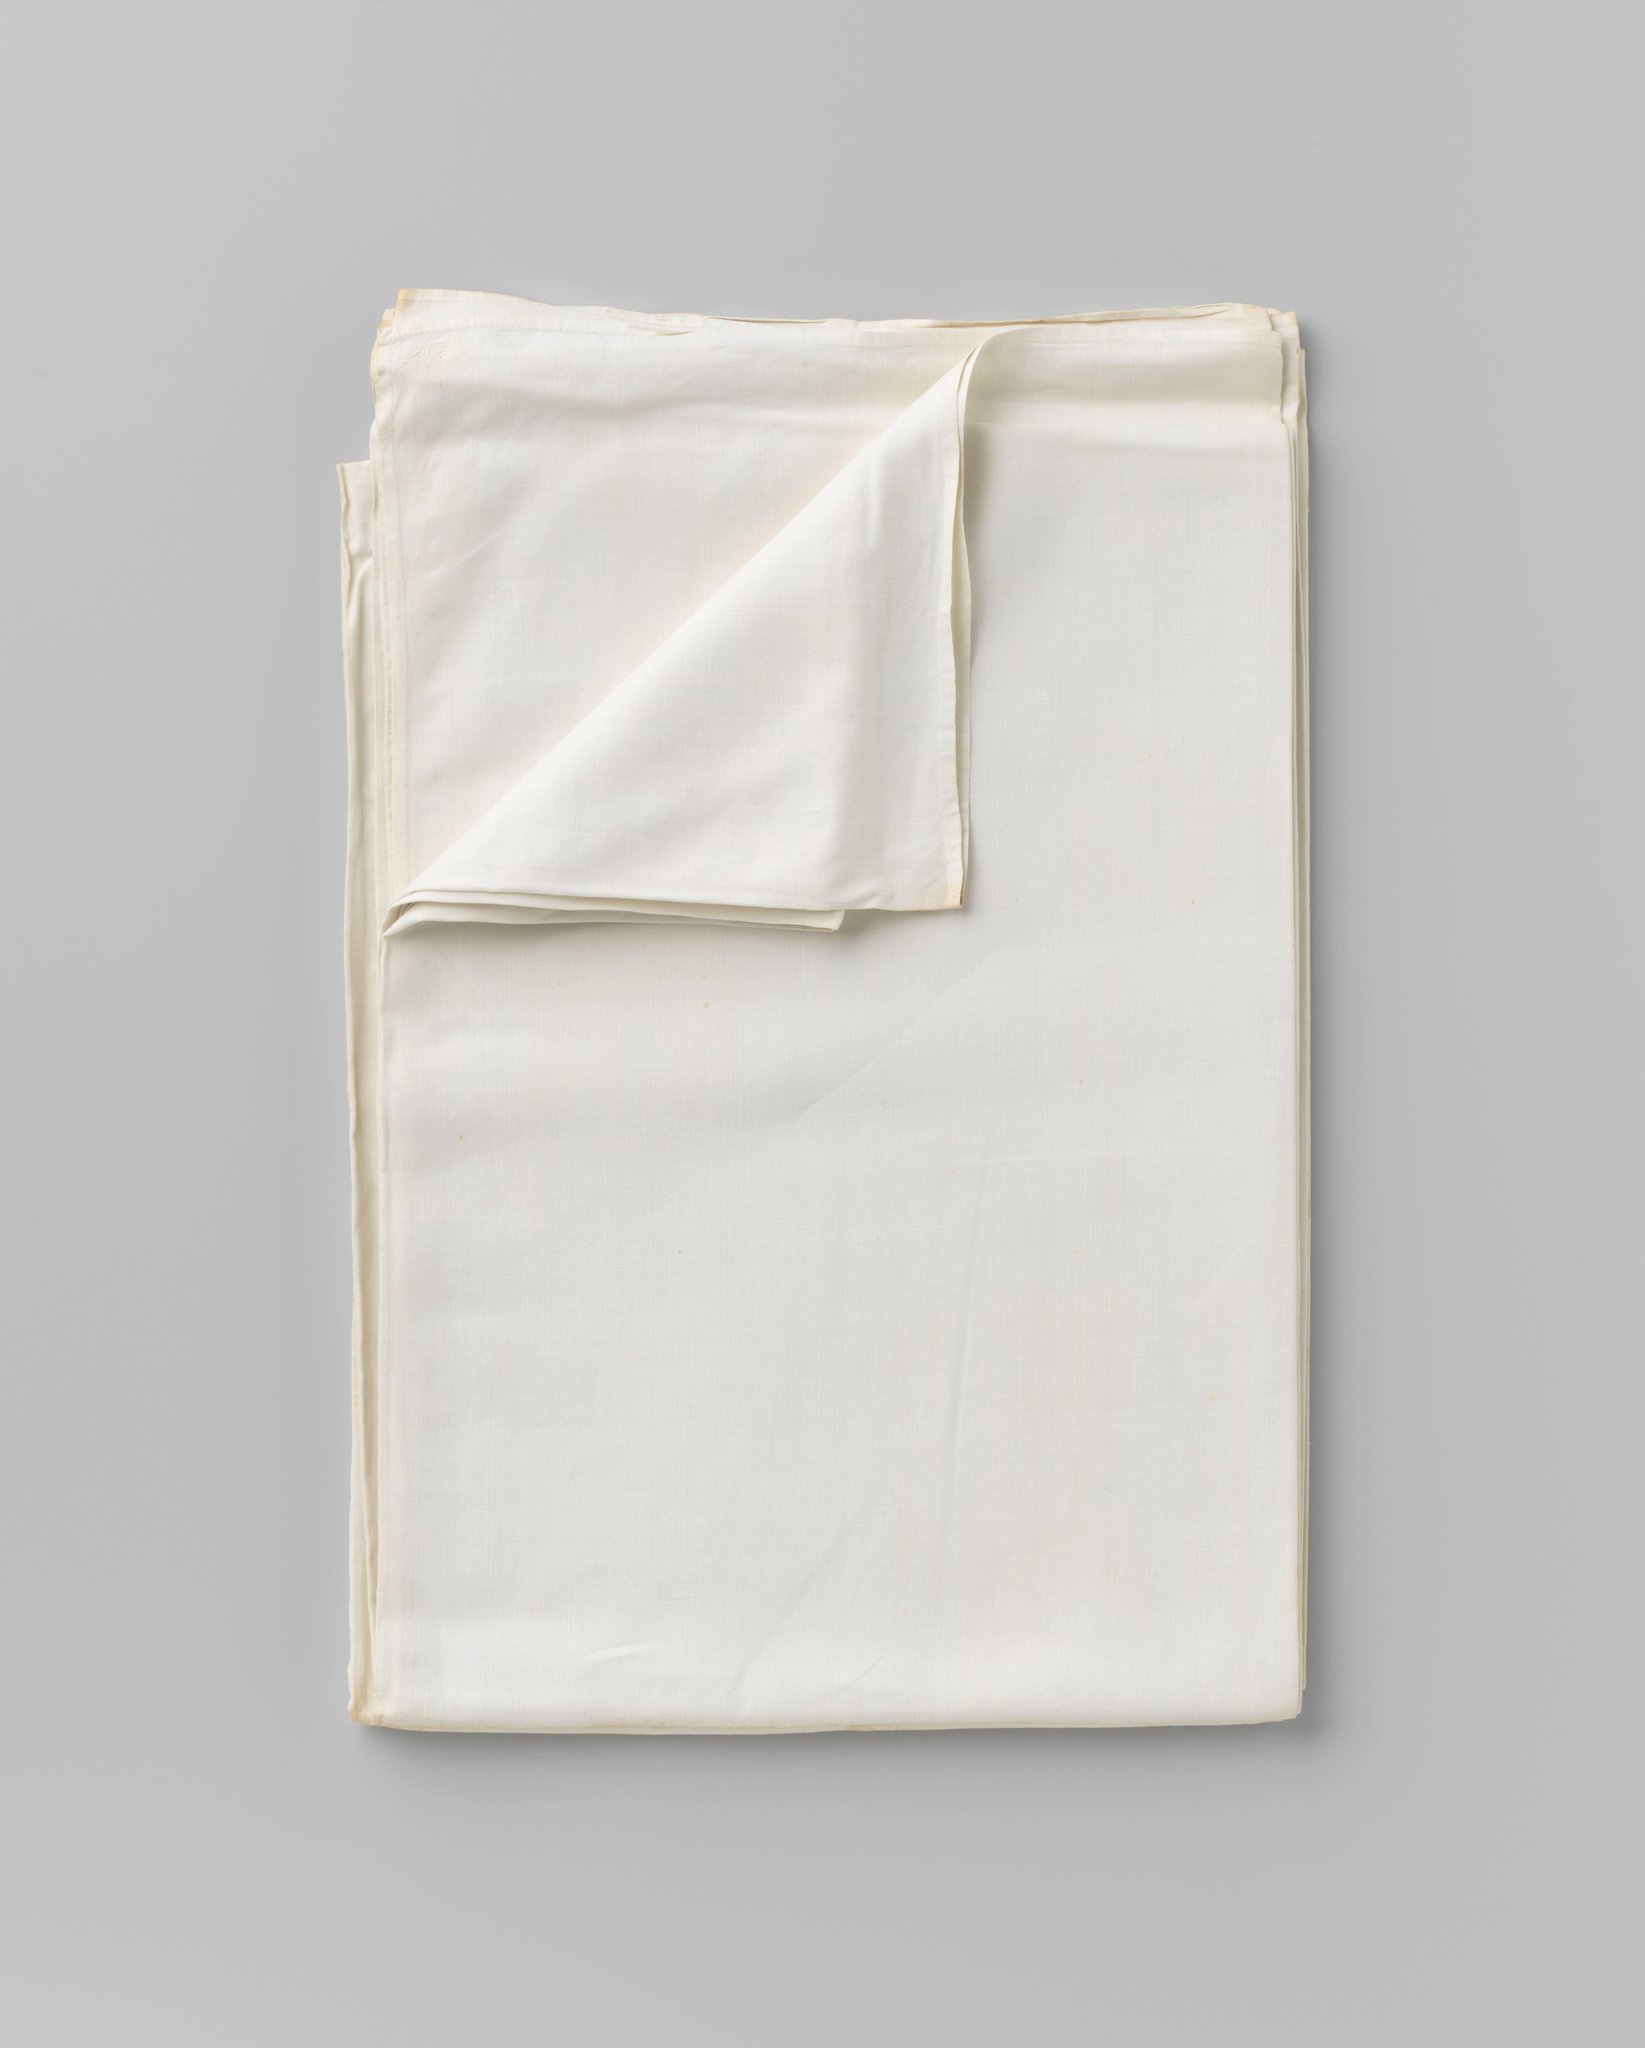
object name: beddenlaken, laken object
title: Laken. Merk: kroon GS 4 en jaartal 1713.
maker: Anonymous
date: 1713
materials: linen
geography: northern netherlands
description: Laken van wit linnen, merk kroon GS 4 en jaartal 1713